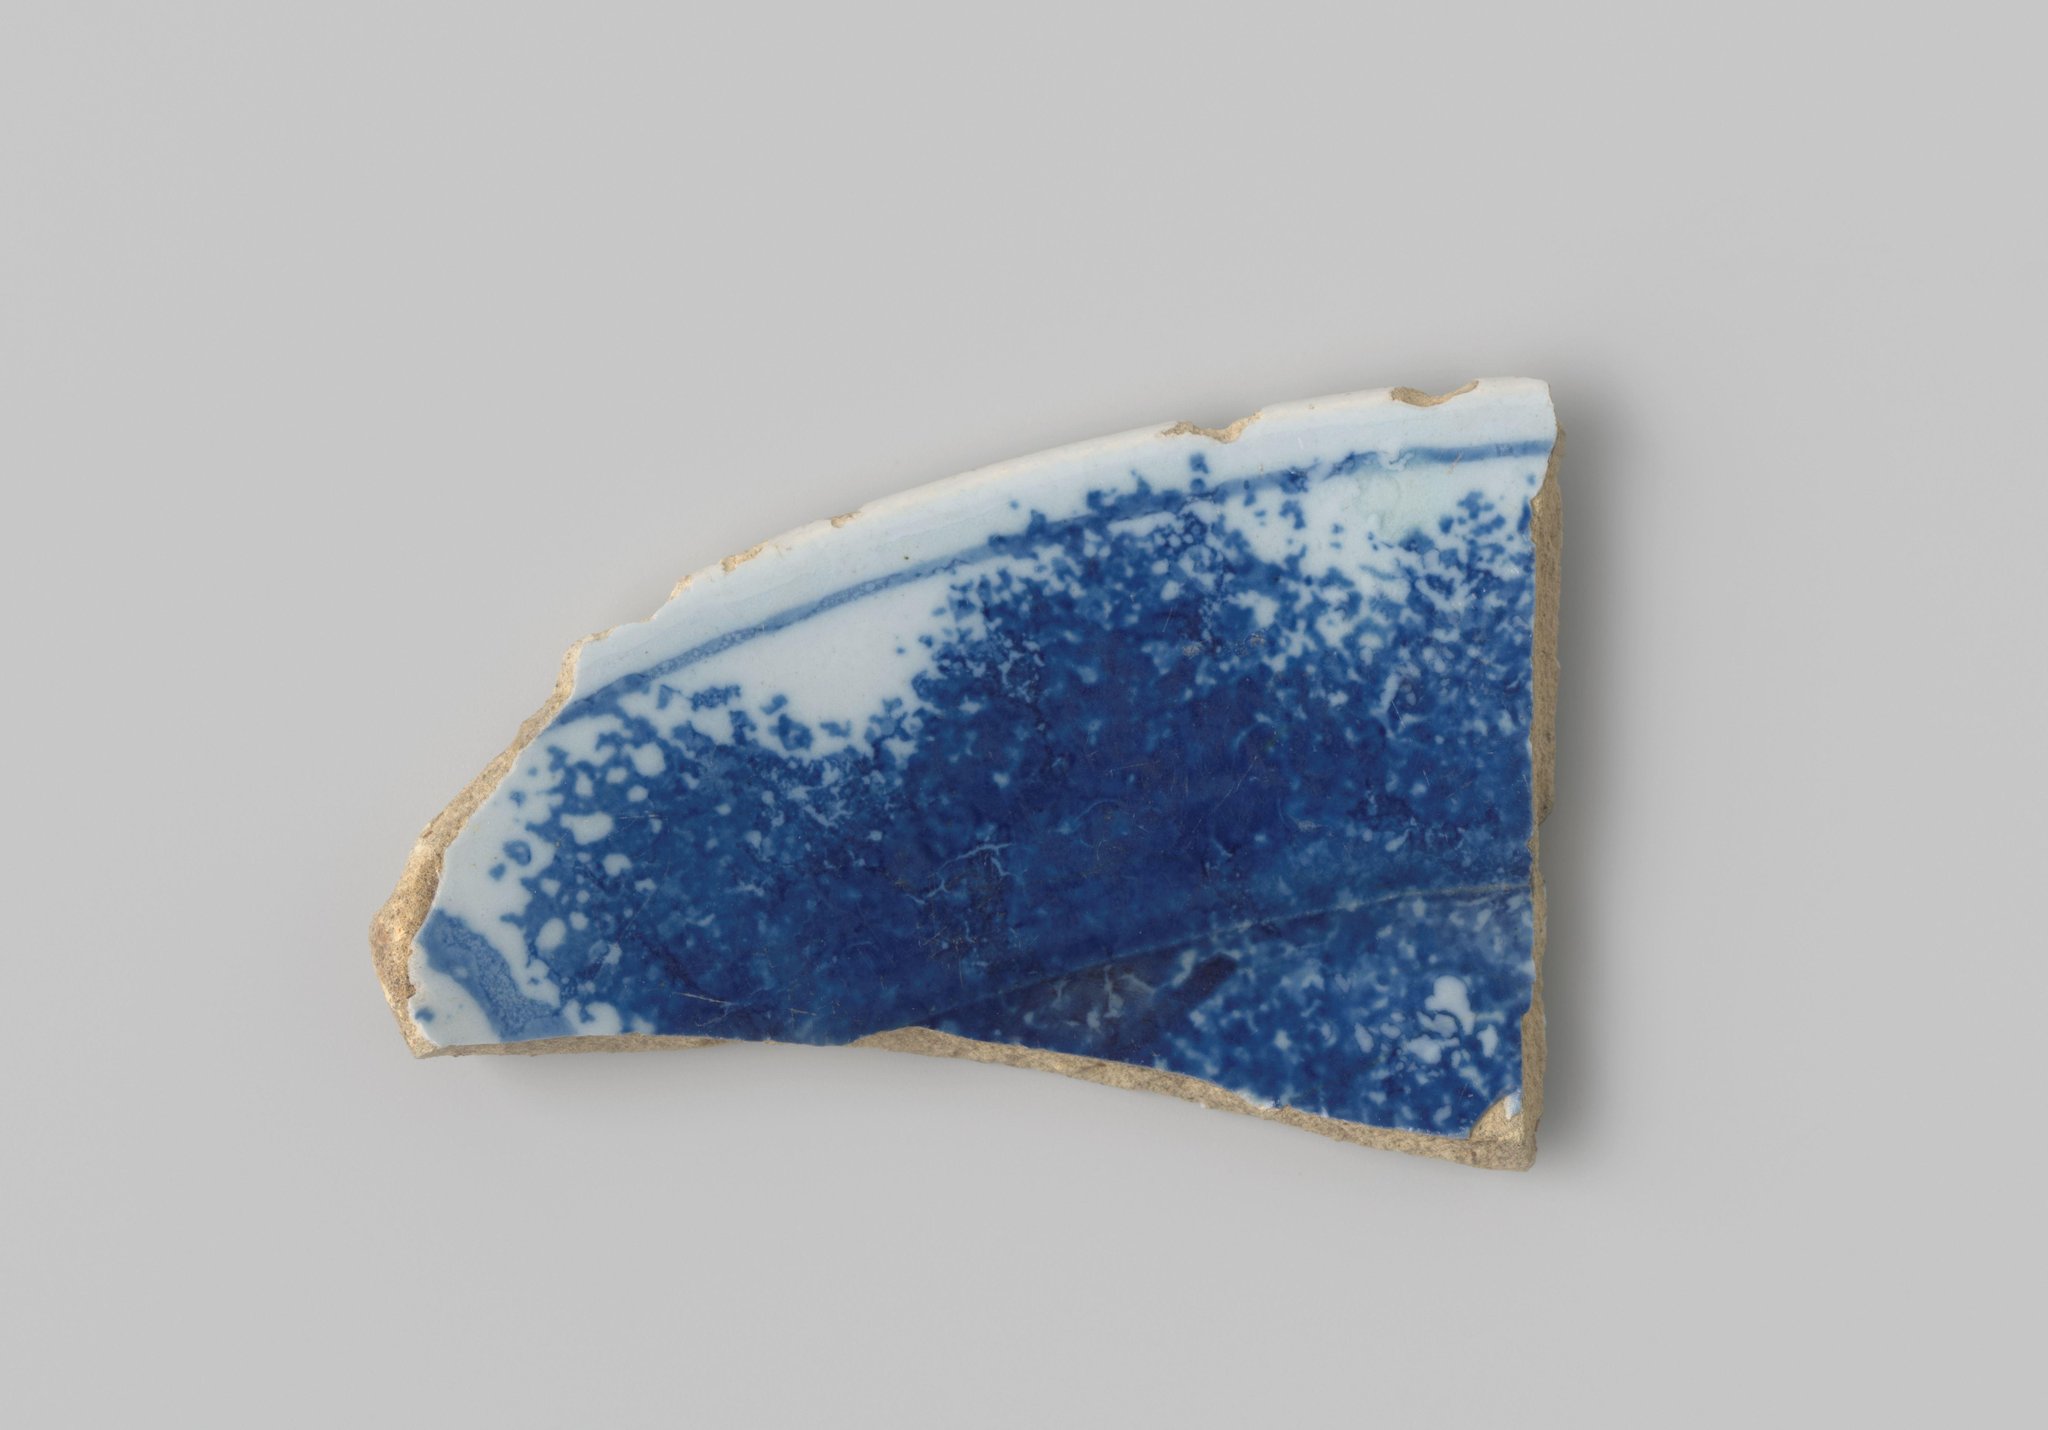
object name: sherd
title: Scherf van witbakkend aardewerk, aan de buitenzijde voorzien van een beschildering in blauw op een witte ondergrond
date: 1500-1899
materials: earthenware, glaze